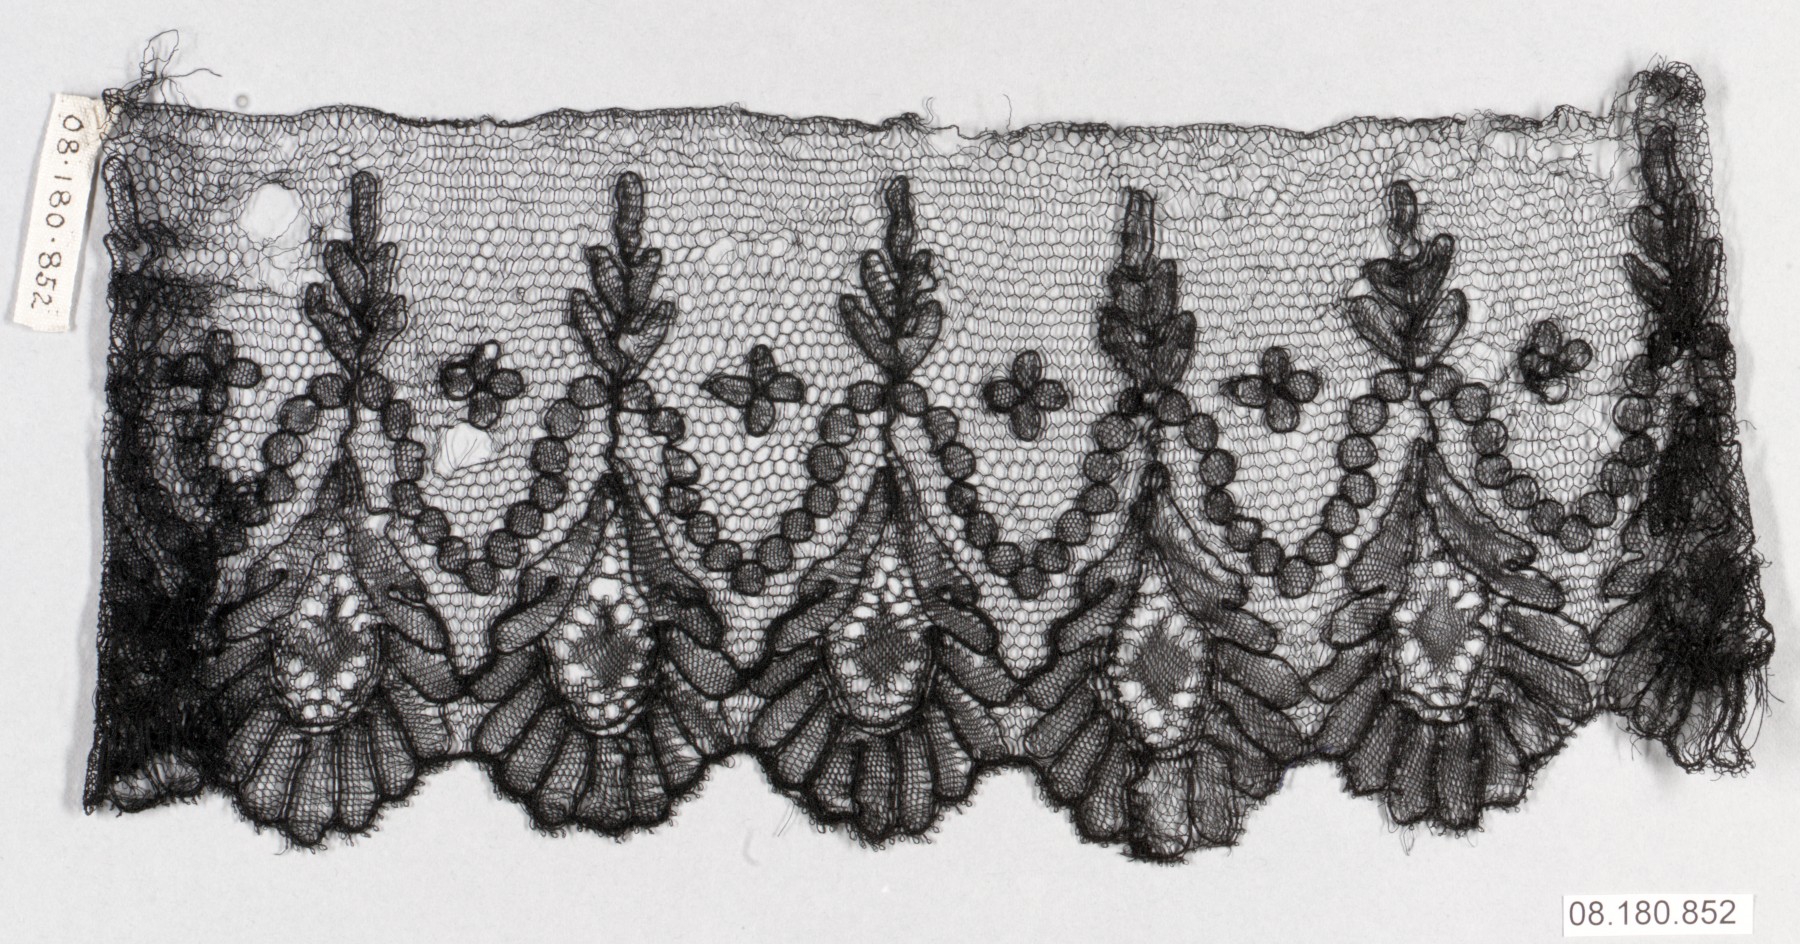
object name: fragment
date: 1801-1900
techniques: lace